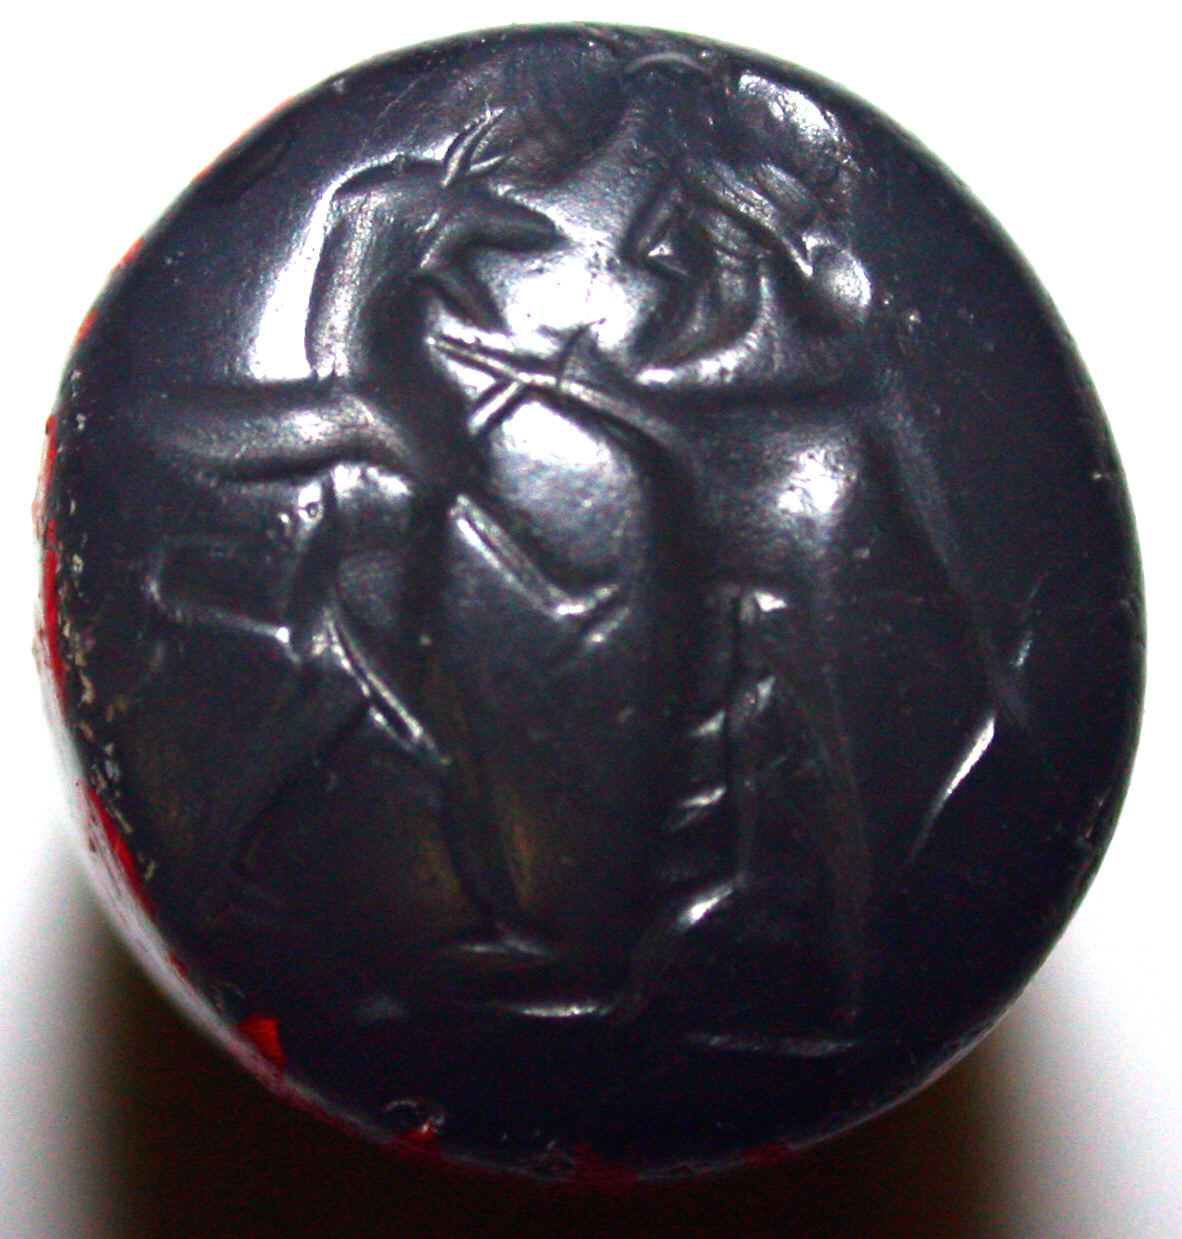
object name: stamp seal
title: Conical seal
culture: achaemenid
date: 600-401 BCE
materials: stone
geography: iran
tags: animals